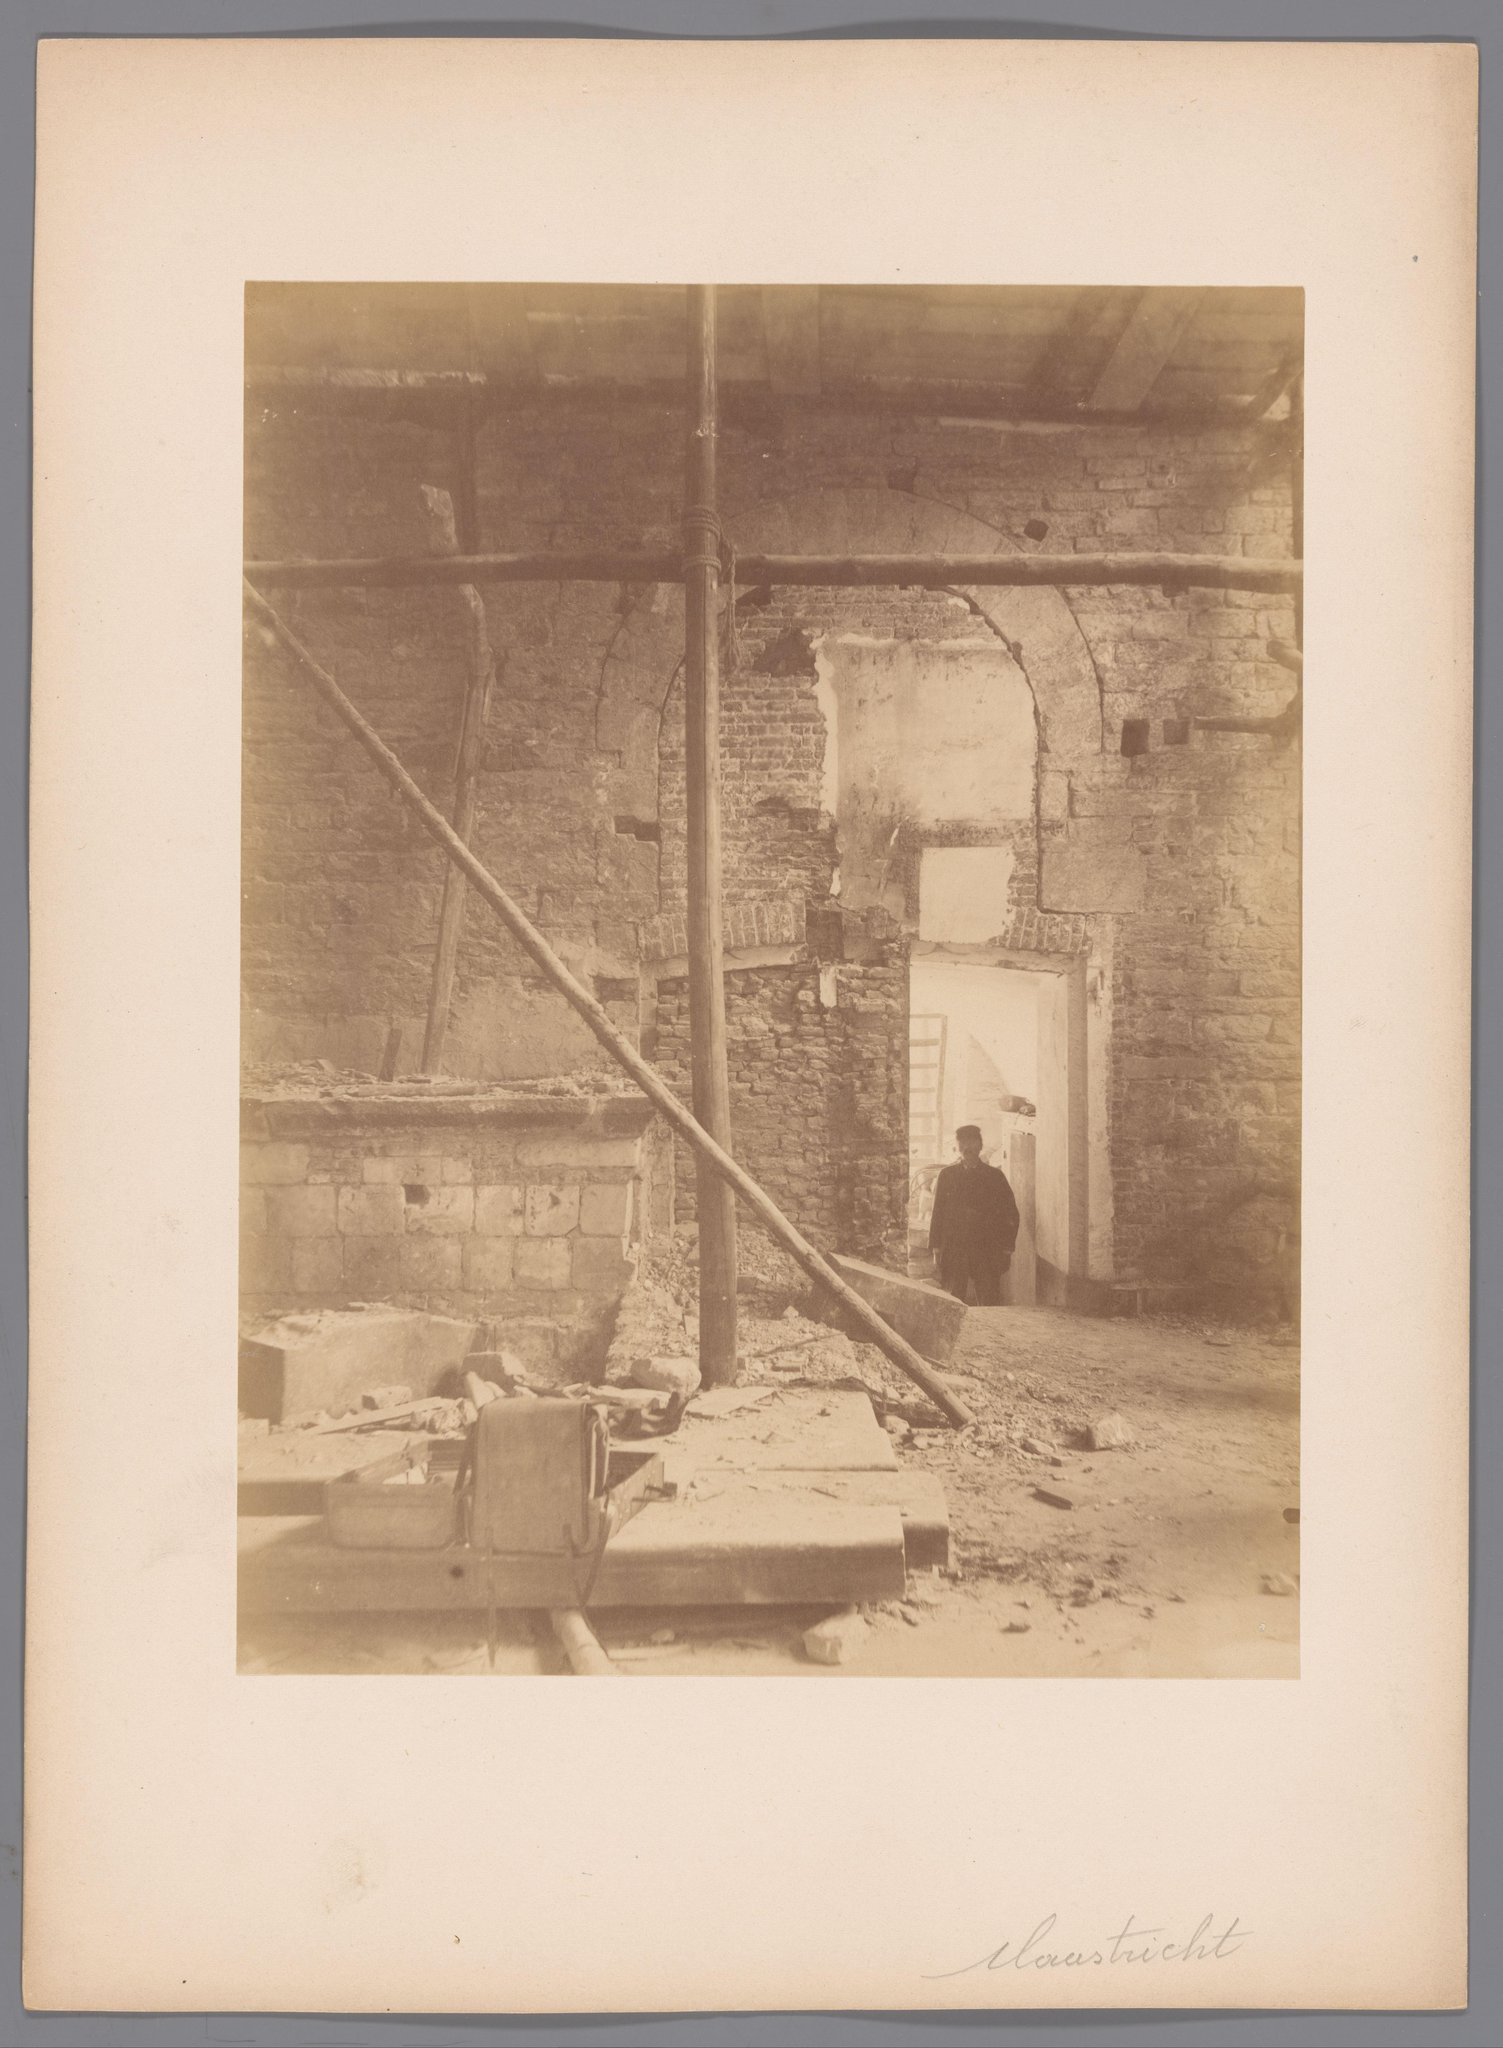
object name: photograph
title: Restauratie van het zuidtransept in de Onze-Lieve-Vrouwebasiliek te Maastricht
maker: anoniem (monumentenzorg)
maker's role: fotograaf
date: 1890-1915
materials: cardboard, photographic support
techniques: albumen print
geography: onze-lieve-vrouwe-basiliek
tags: parts of church interior: transept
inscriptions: annotation: ‘O.L.V. kerk Maasricht/ restauratie zuidtransept/ aanzicht oostmuur beneden’, annotation: ‘Maastricht’